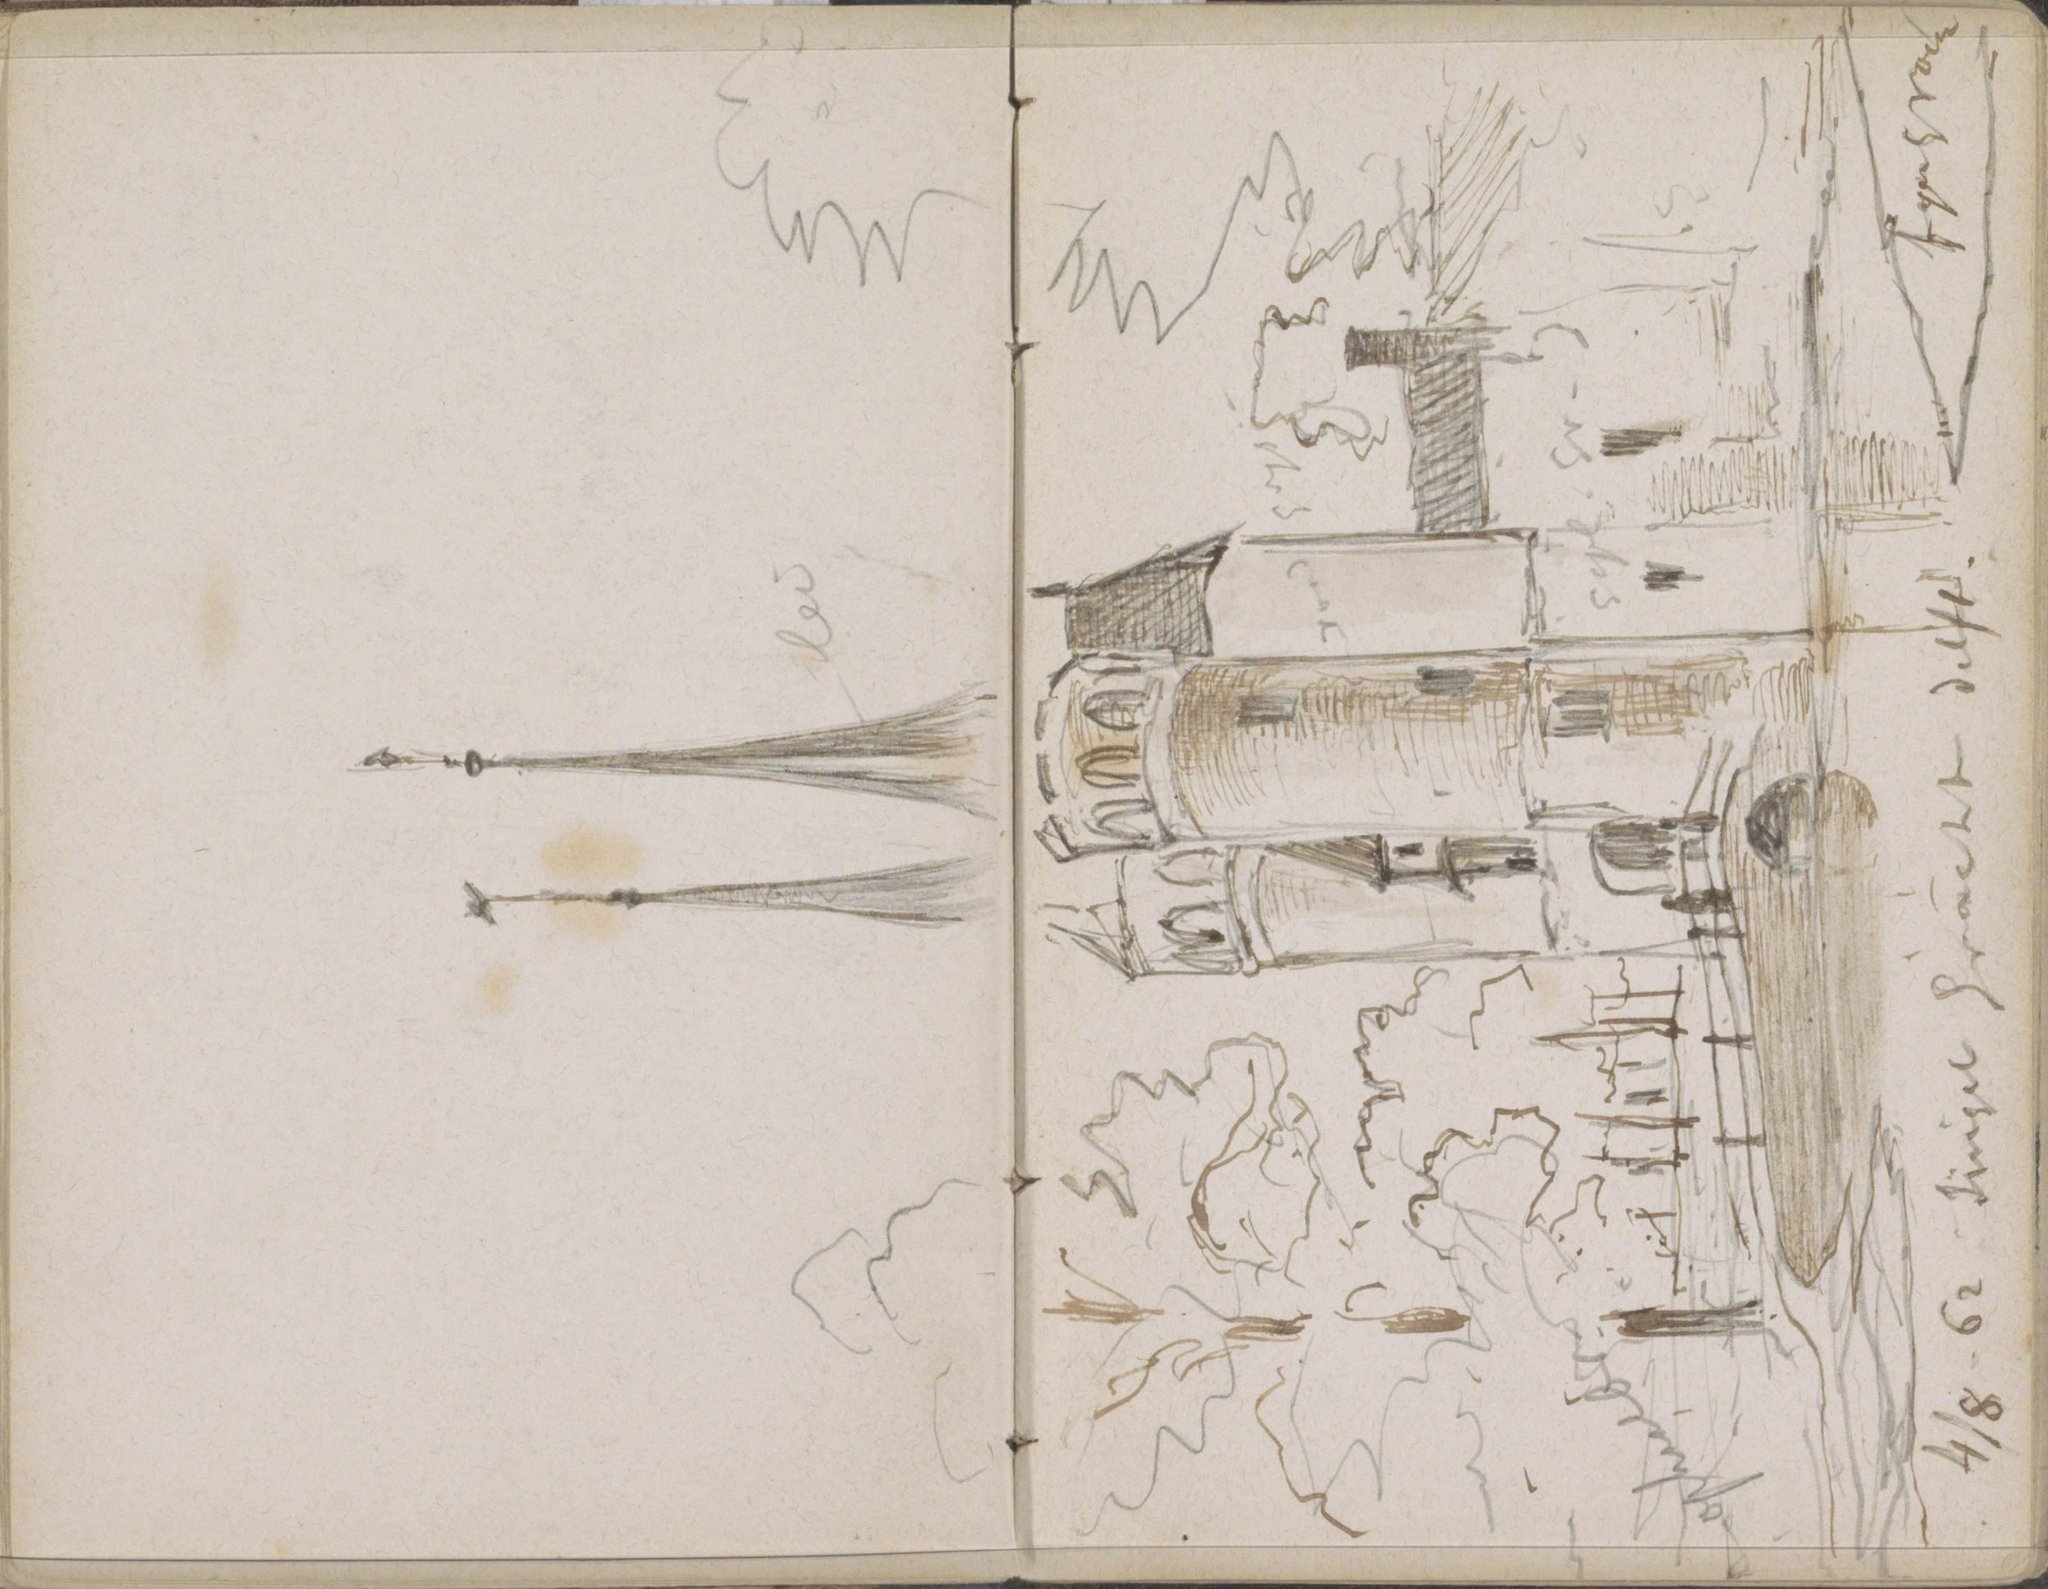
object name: sketchbook leaf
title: Singelgracht in Delft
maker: johannes tavenraat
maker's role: draughtsman, painter, print maker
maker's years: 1809-1881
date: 1808-1862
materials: ink, paper, pencil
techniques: brush, pen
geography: delft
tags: canal, street, tower (of house or building), delft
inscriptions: date and inscription: ‘4/8 62 Singel gracht delft’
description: Blad 26 verso en 27 recto uit een schetsboek met 65 bladen.